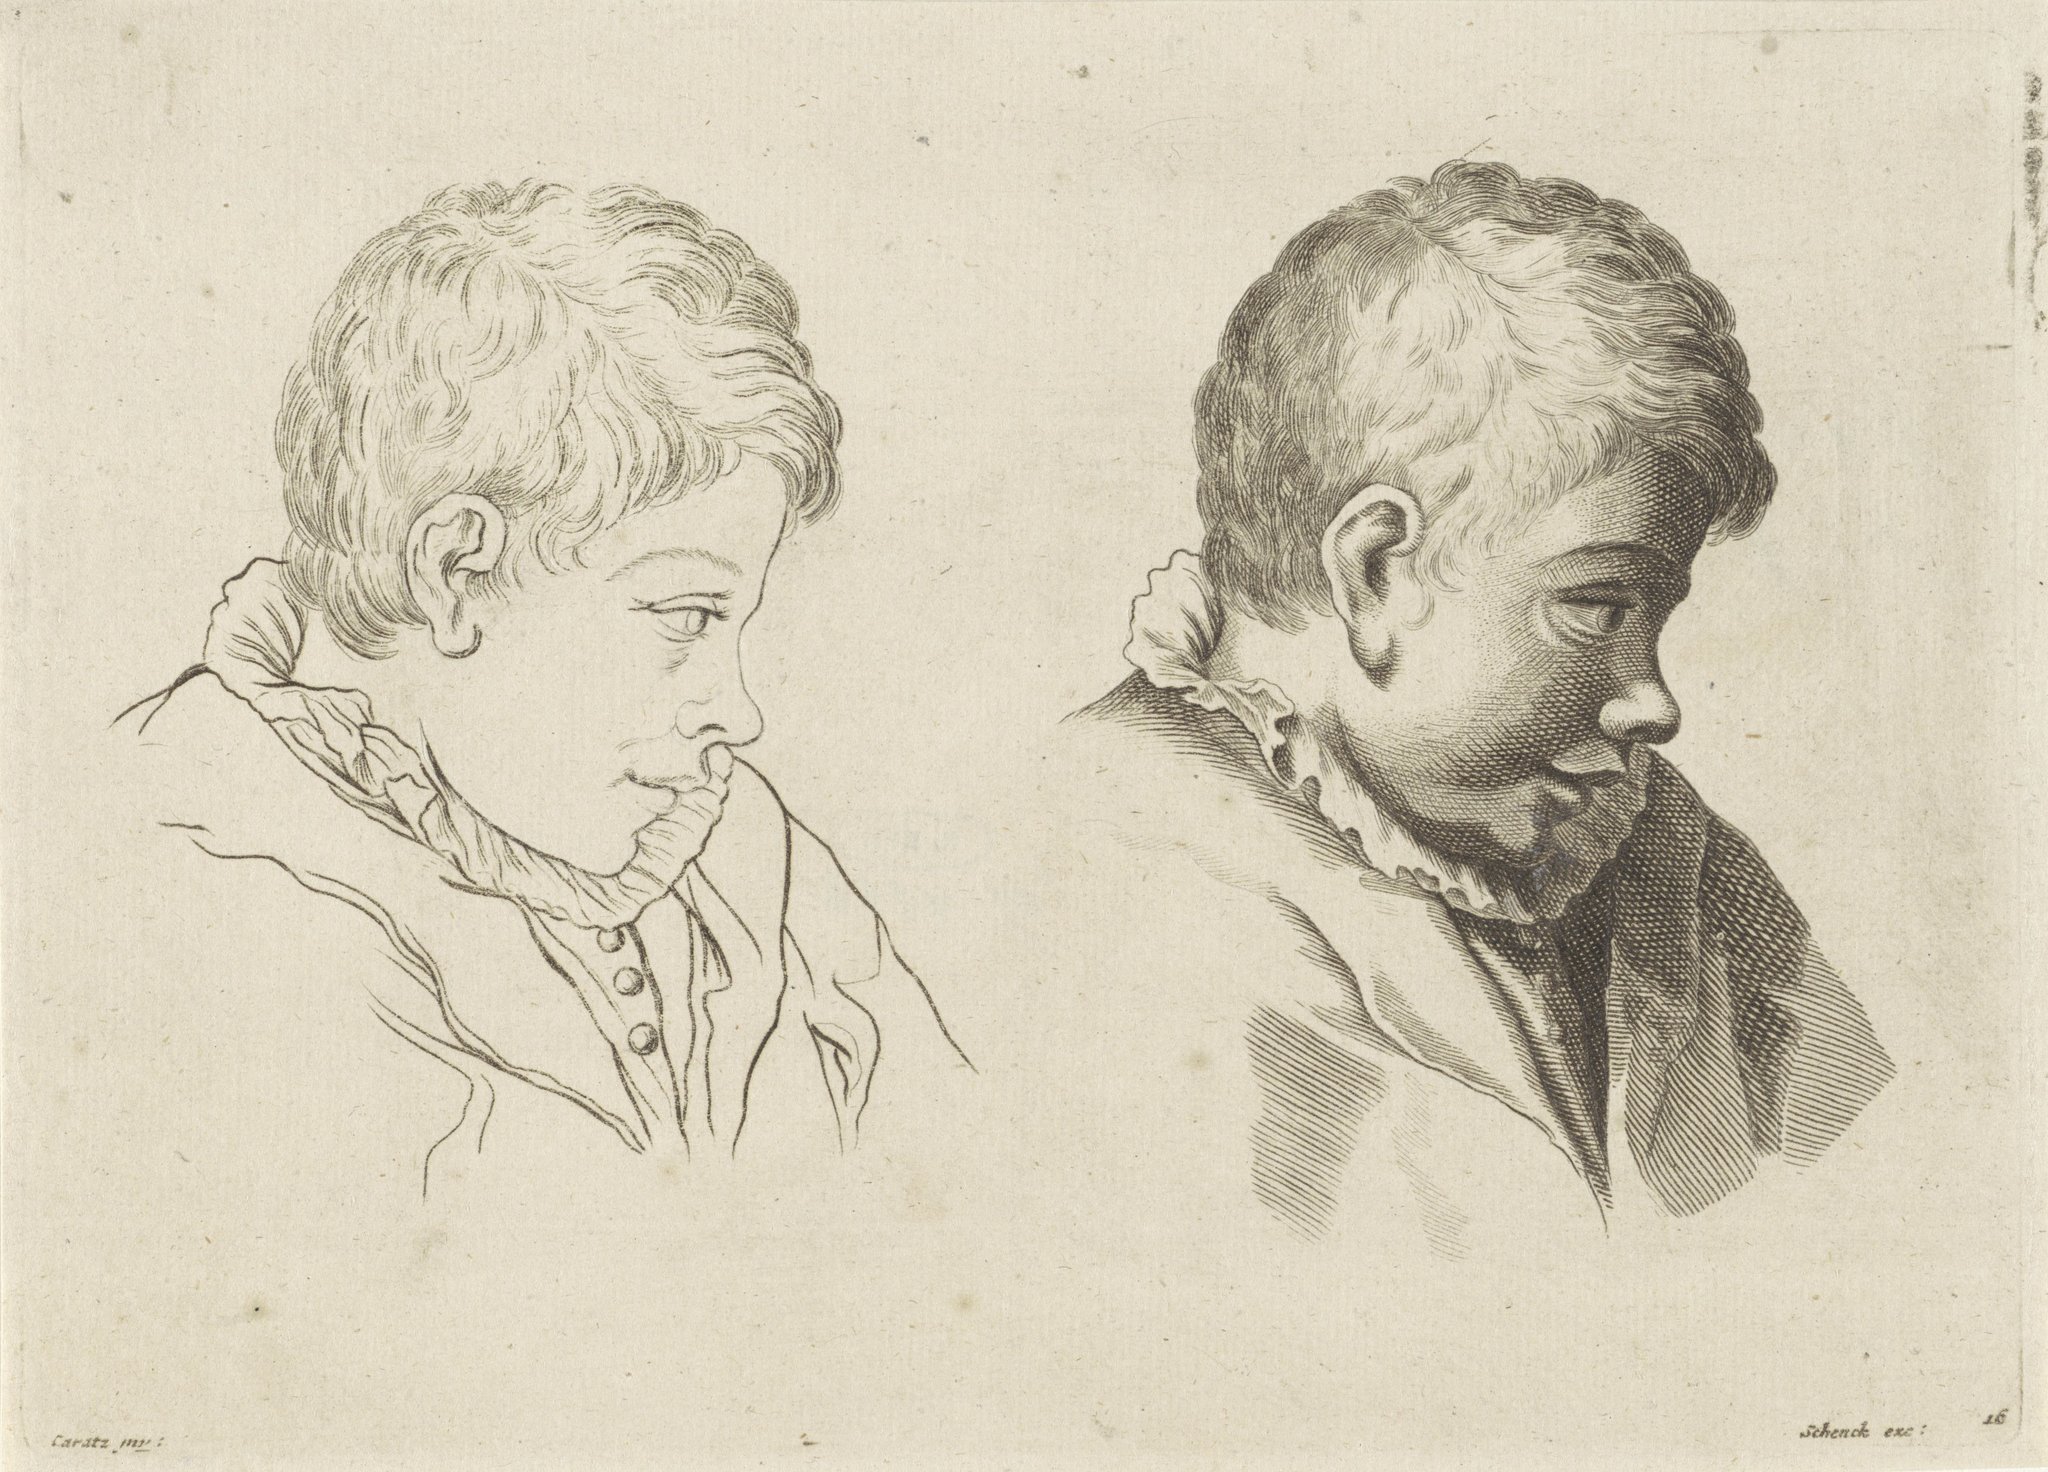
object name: print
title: Figuren naar Annibale Carracci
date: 1675-1711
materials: paper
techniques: engraving, etching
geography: amsterdam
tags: child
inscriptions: collector's mark: Lugt 2228